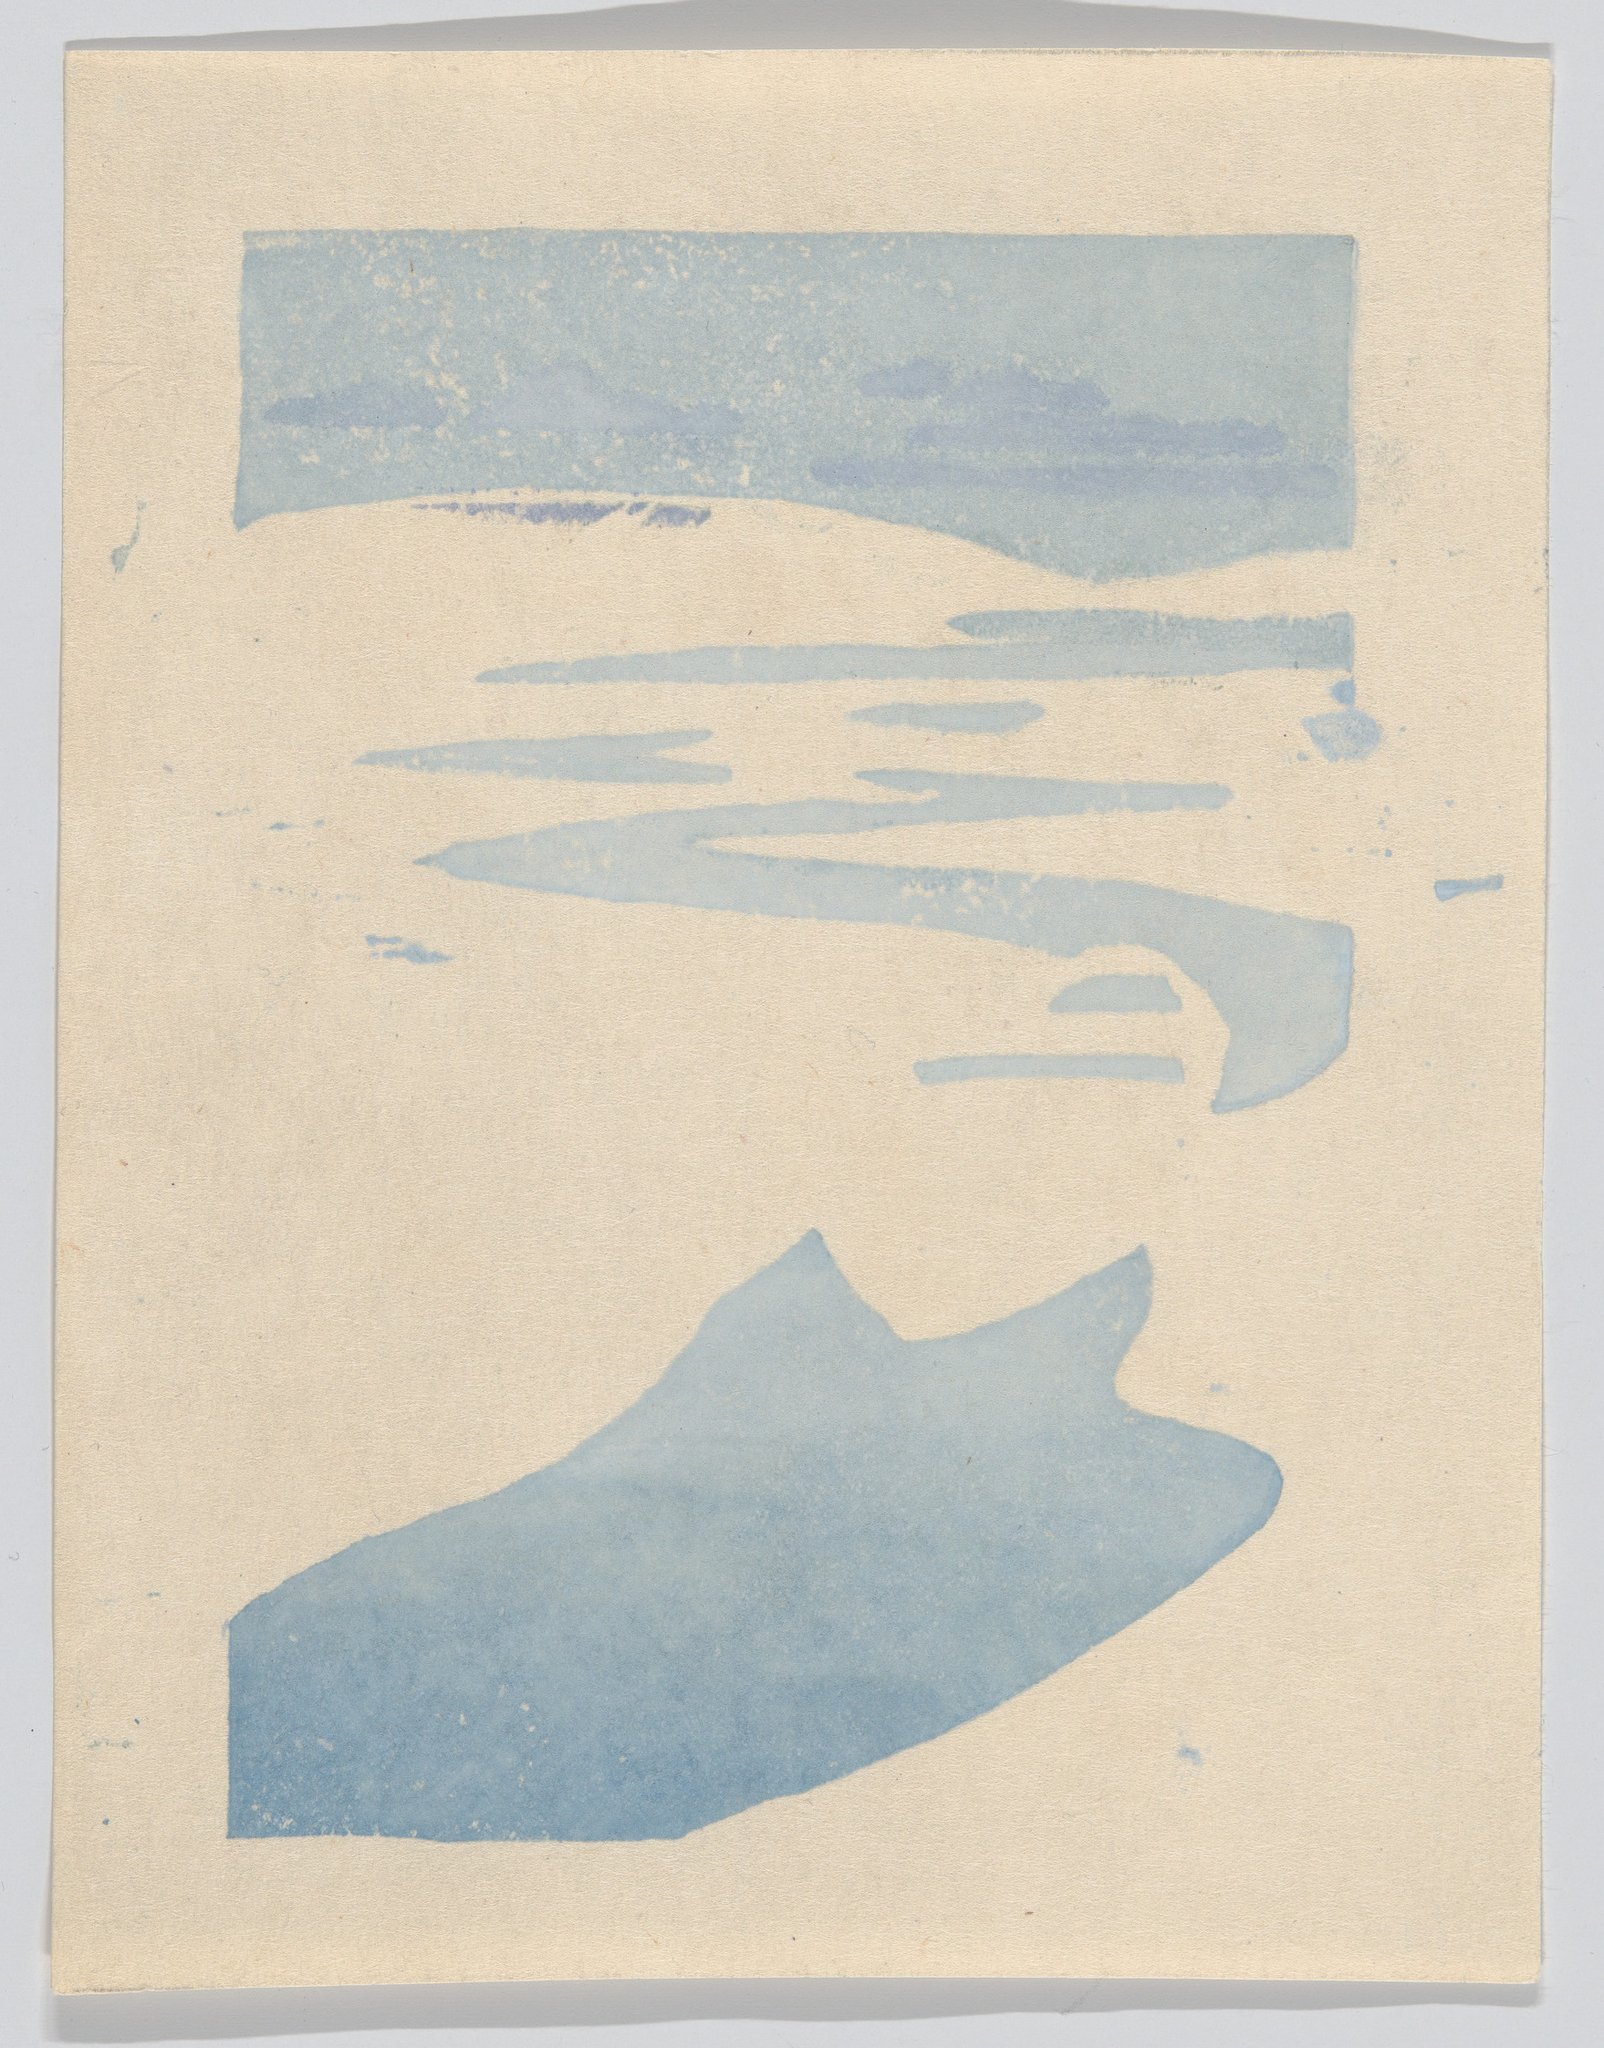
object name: proof print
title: "The Derelict" or "The Lost Boat"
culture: american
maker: arthur wesley dow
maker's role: artist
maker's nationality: american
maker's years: 1857-1922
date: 1916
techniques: woodcut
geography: united states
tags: abstraction